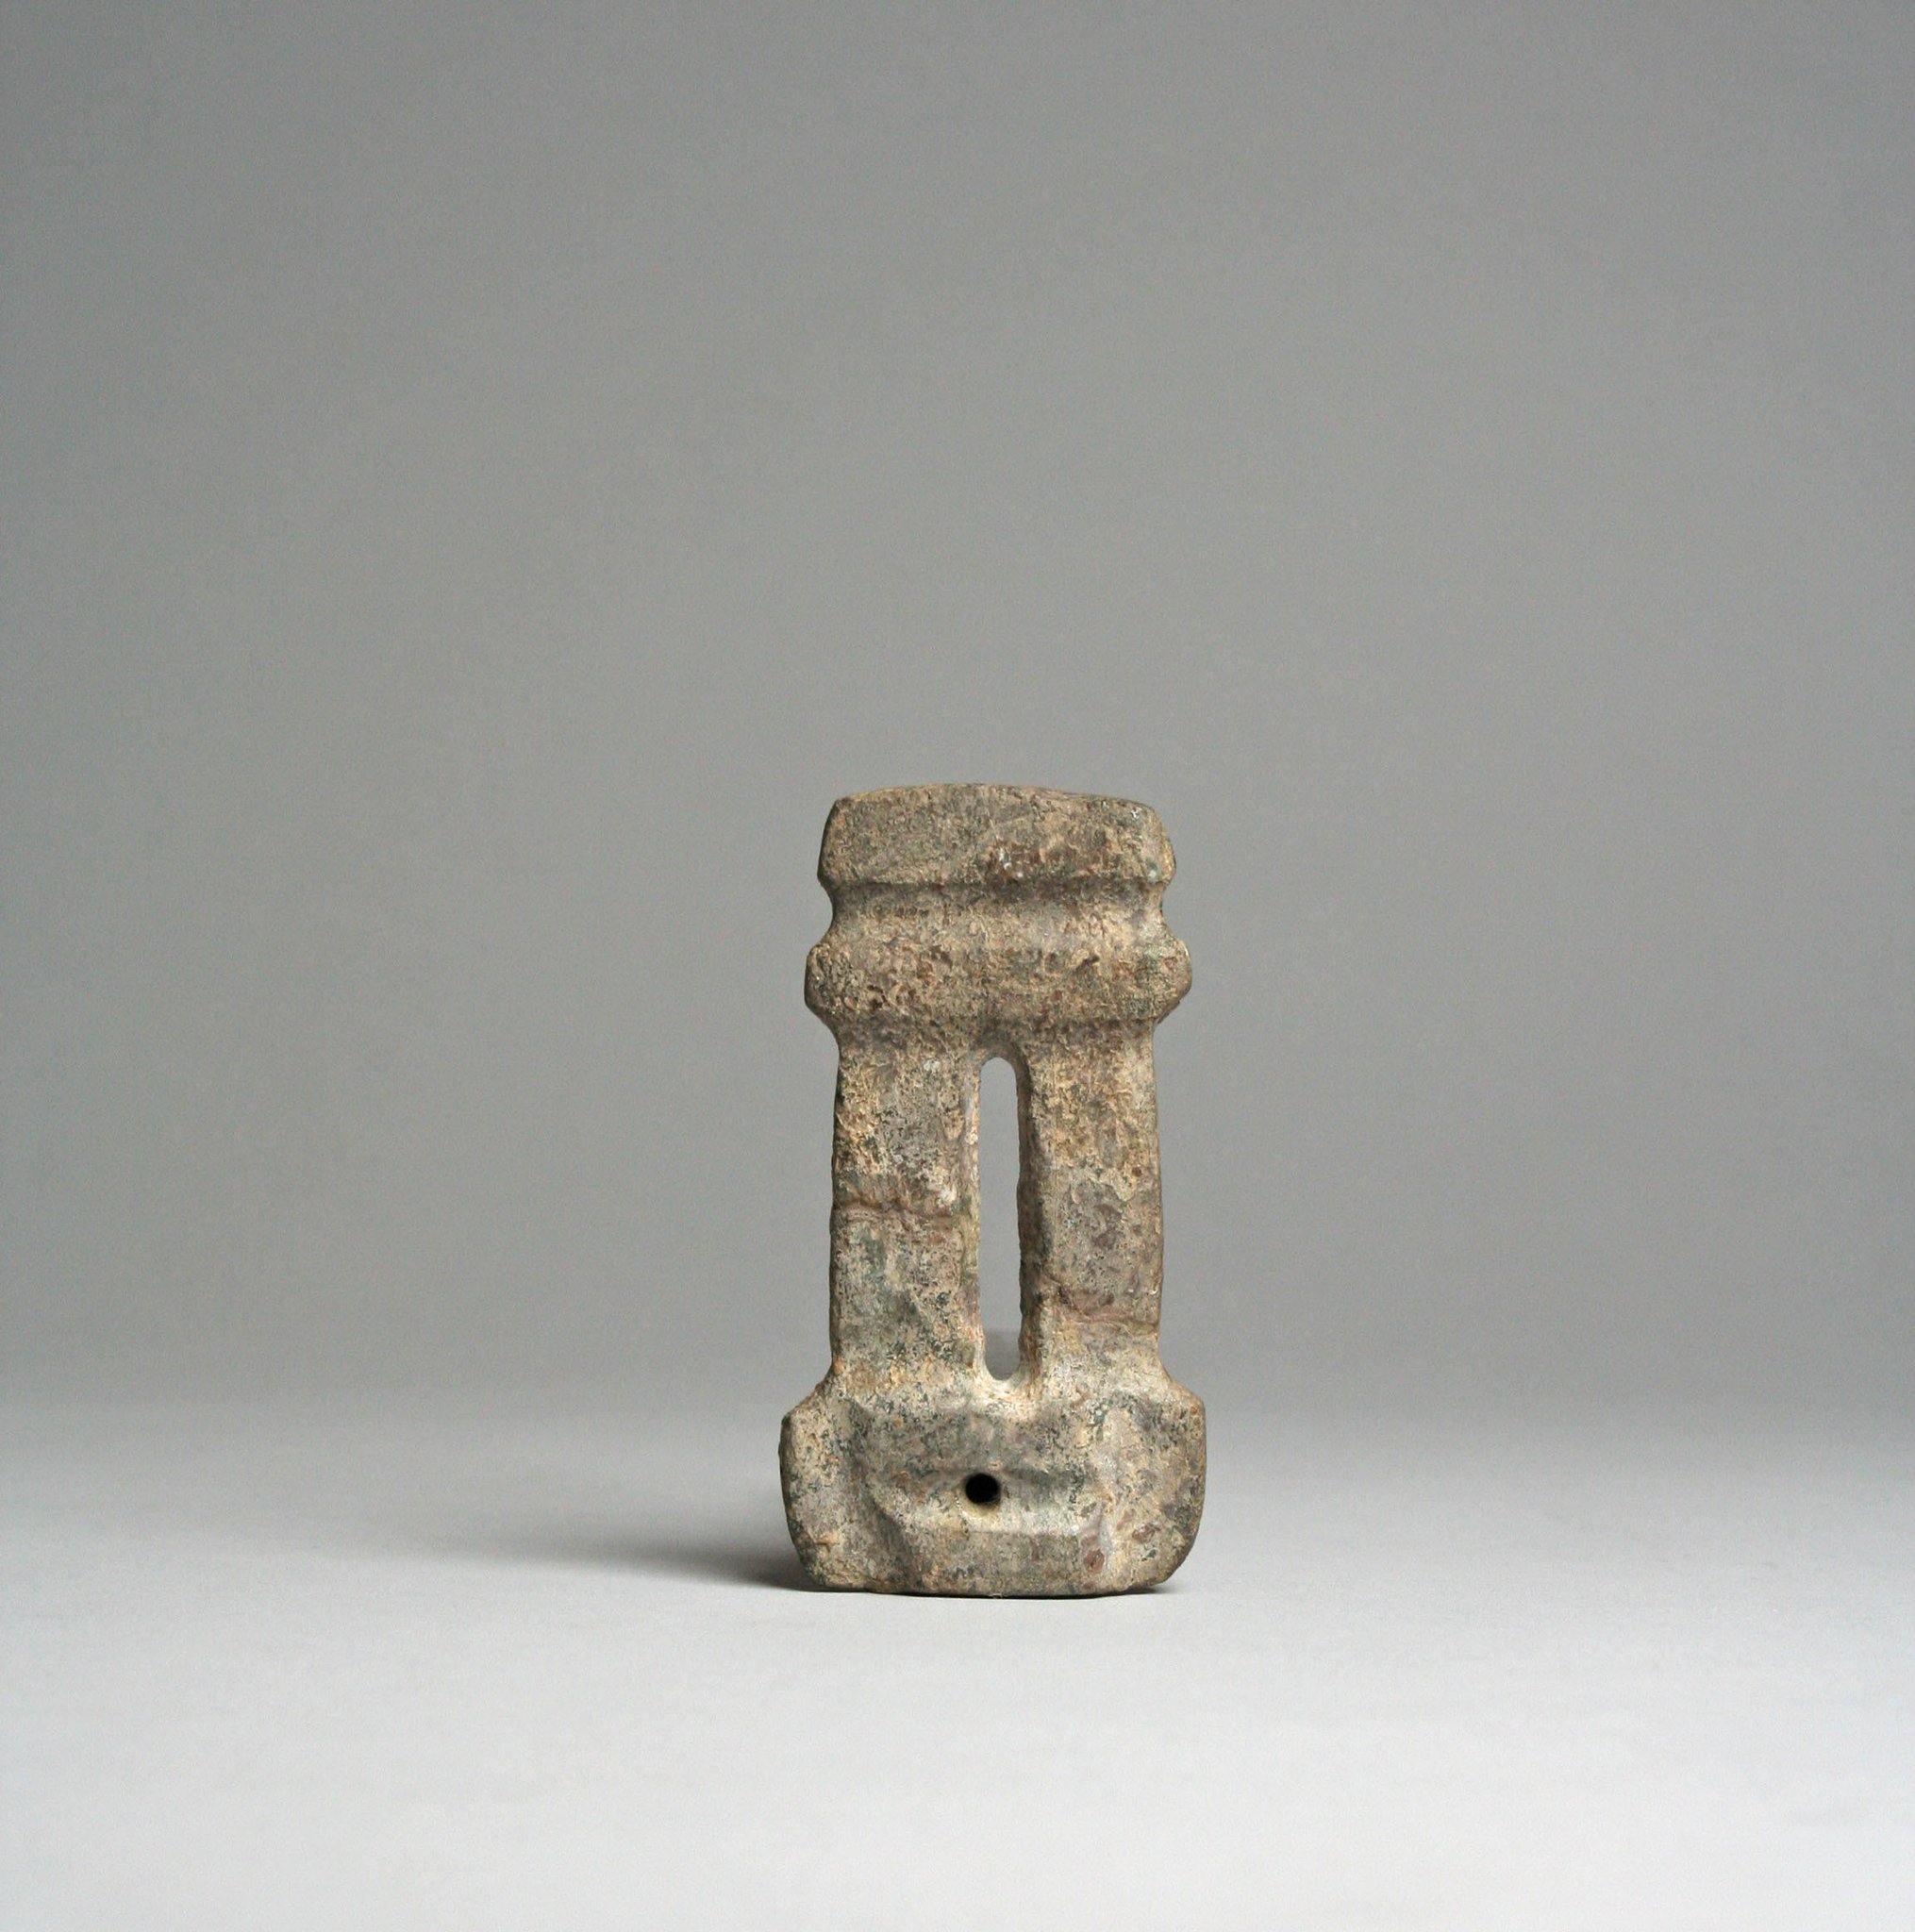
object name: architectural model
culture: mezcala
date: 1-800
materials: stone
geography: mexico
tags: temples